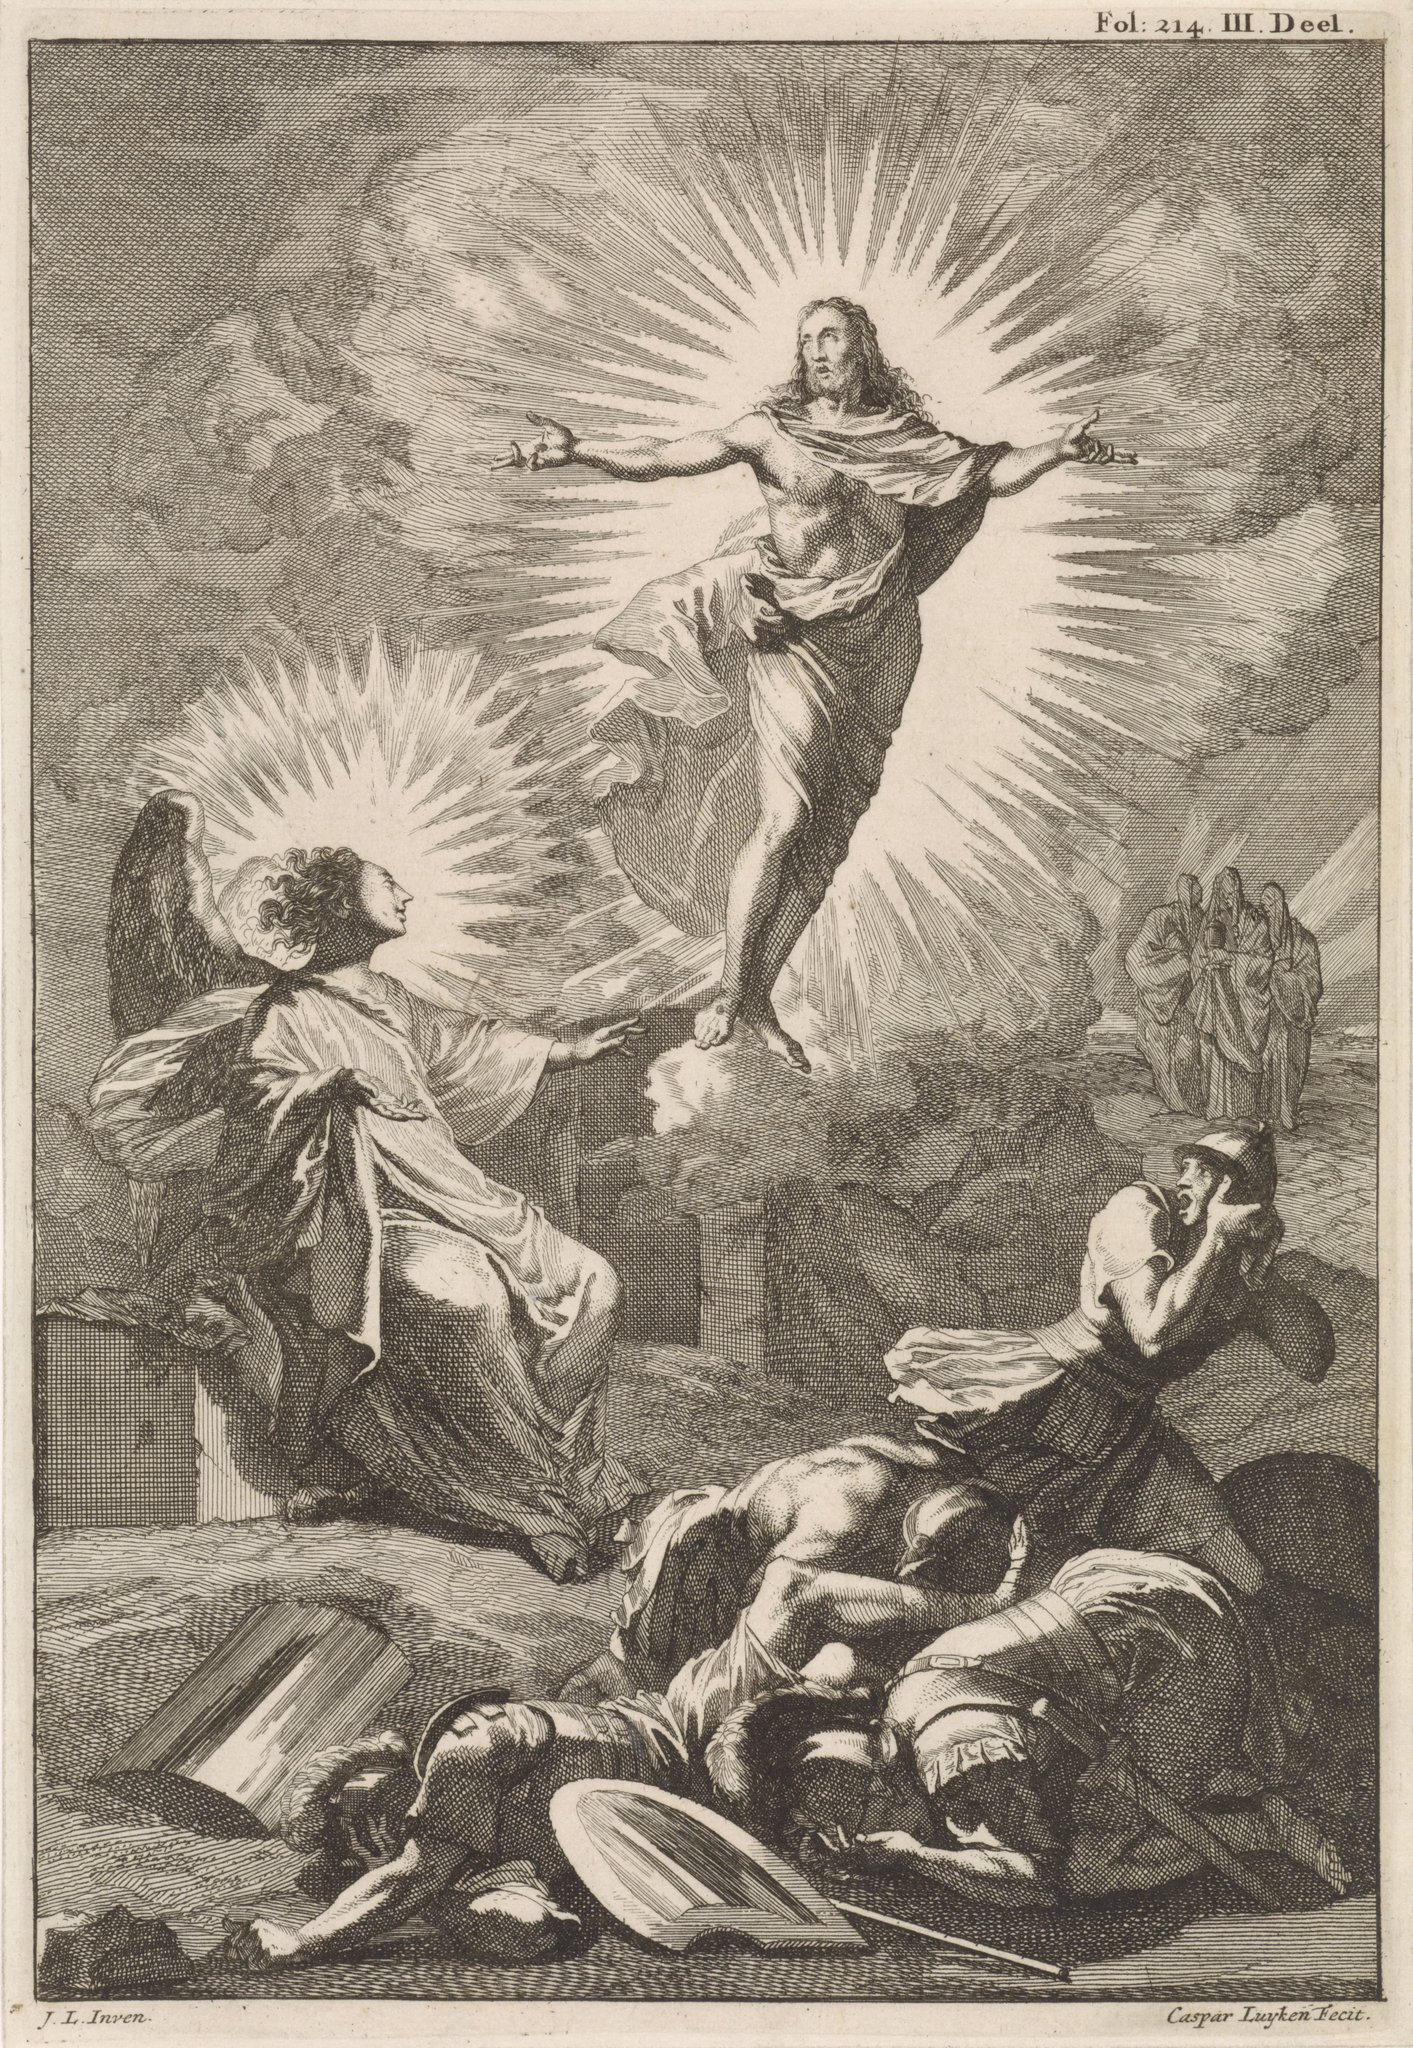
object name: print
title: Opstanding van Christus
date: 1700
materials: paper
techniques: etching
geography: nuremberg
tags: christ, usually holding a banner, arises from the grave; often combined with sleeping and/or frightened soldiers (+ angel(s)), the holy women (the three maries) on their way to or at the tomb, to anoint christ's body, crucified christ with mary and john on either side of the cross; holy rood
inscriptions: collector's mark: Lugt 2228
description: Christus verrijst uit zijn graf. Naast zijn graf een engel. Rechts vluchten soldaten weg of knielen uit angst en op de achtergrond rechts de drie vrouwen die naar het graf gaan.